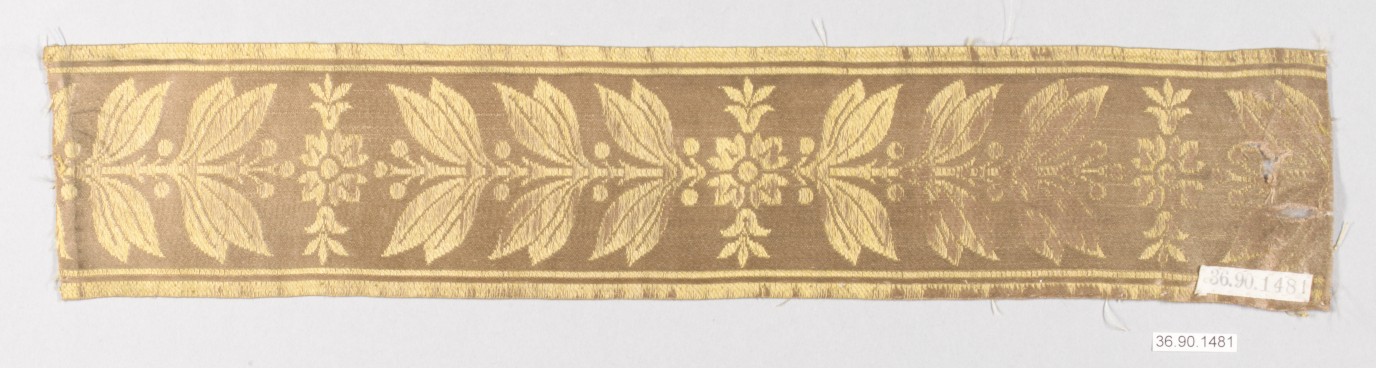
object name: ribbon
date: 1801-1900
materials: silk